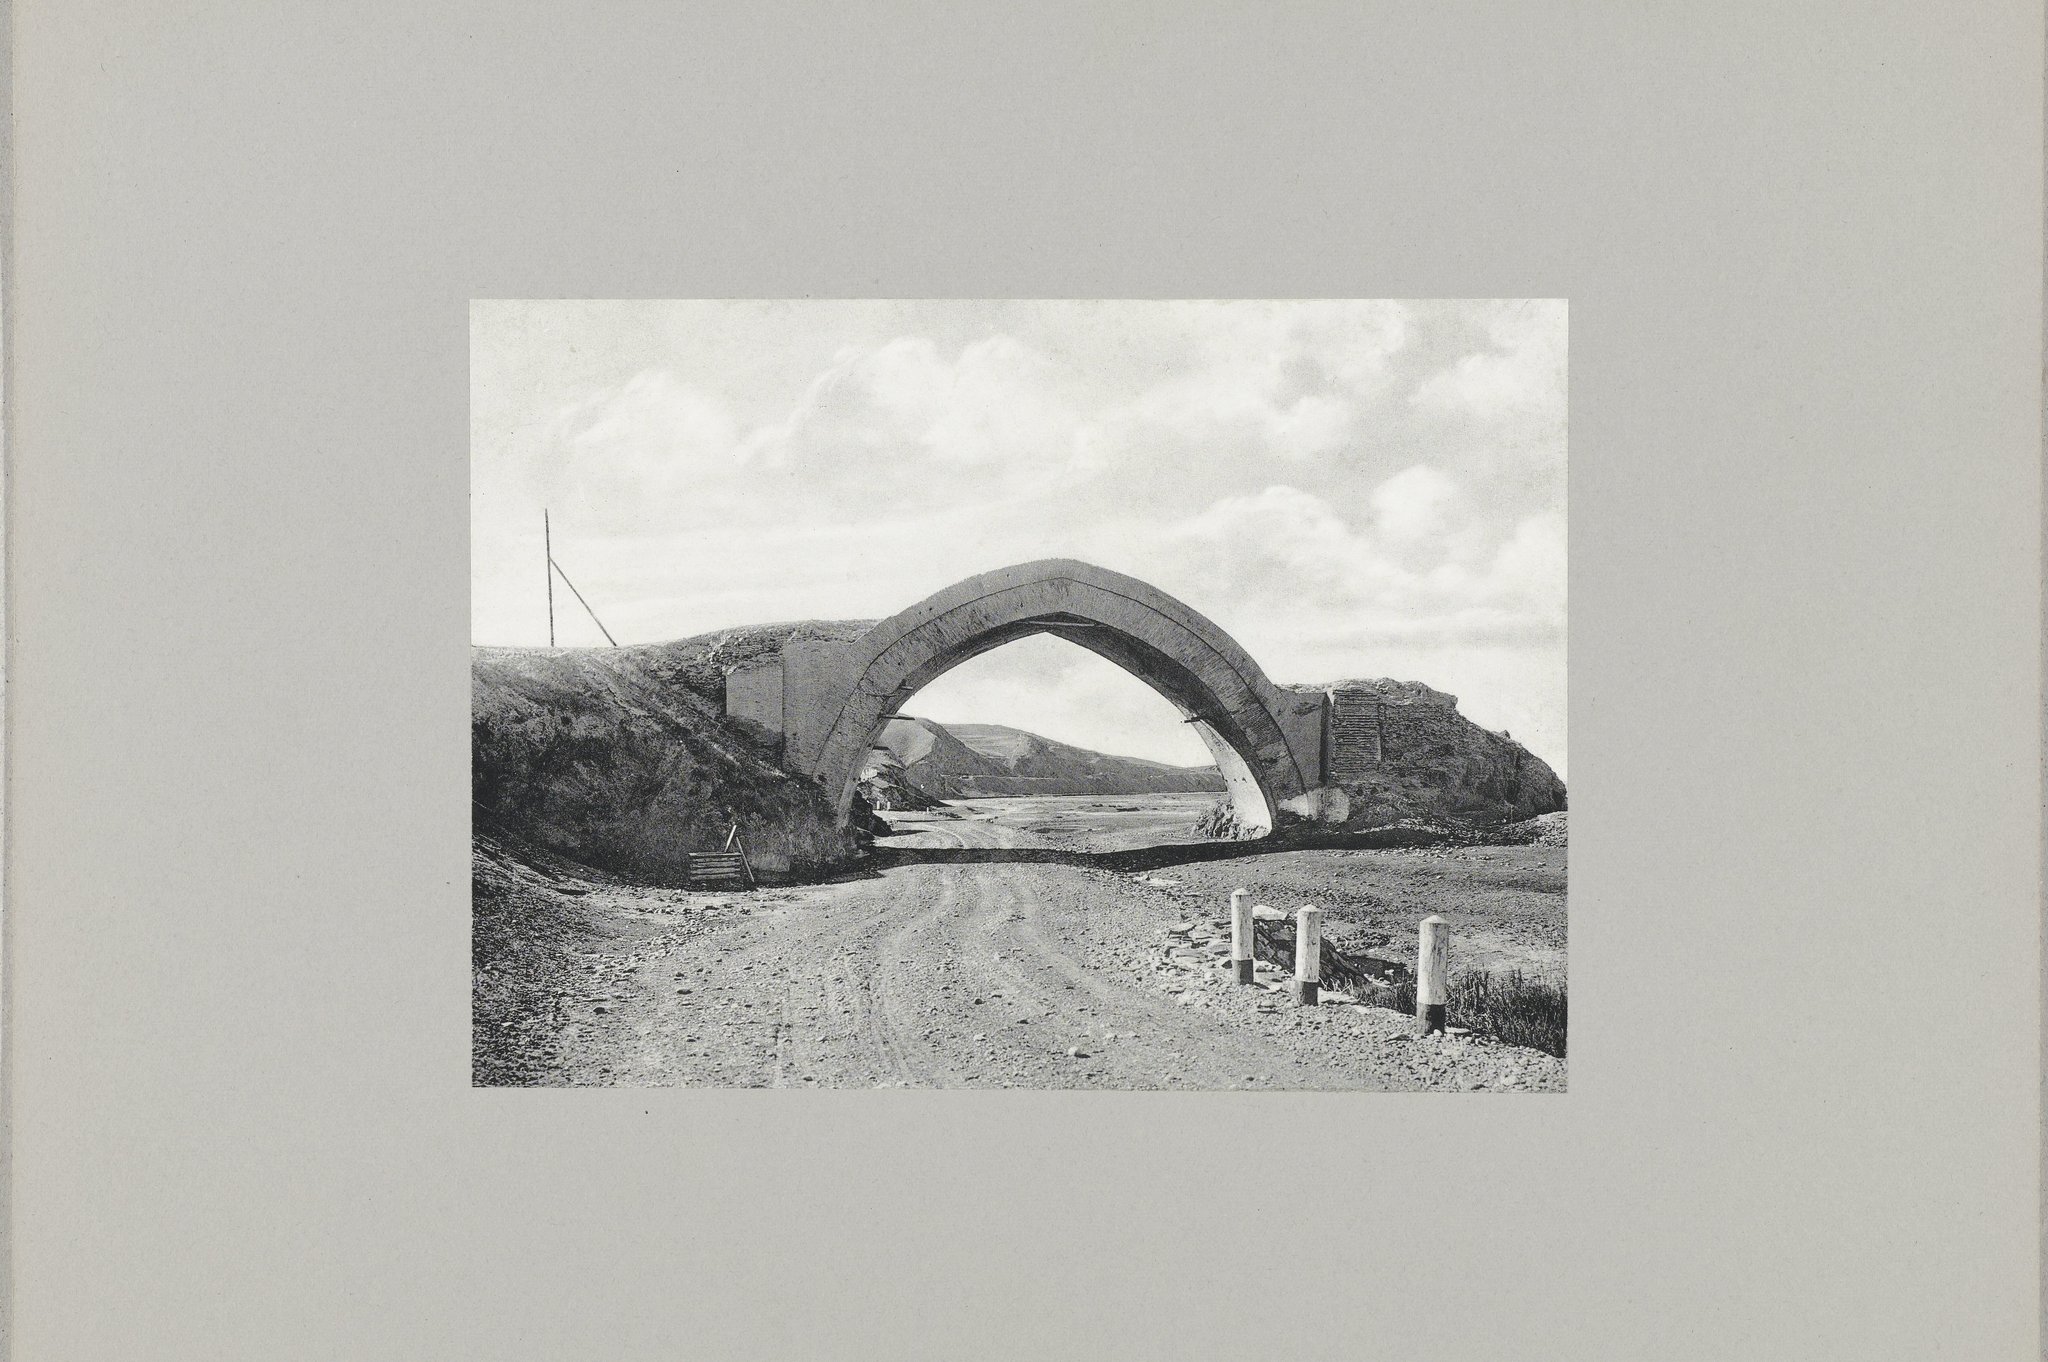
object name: photomechanical print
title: Brug van Tamerlan buiten Samarkand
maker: Anonymous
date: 1895-1915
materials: cardboard, paper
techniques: photograph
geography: uzbekistan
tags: uzbekistan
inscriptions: annotation: ‘20. Brug van Tamerlan buiten Samarkand.’